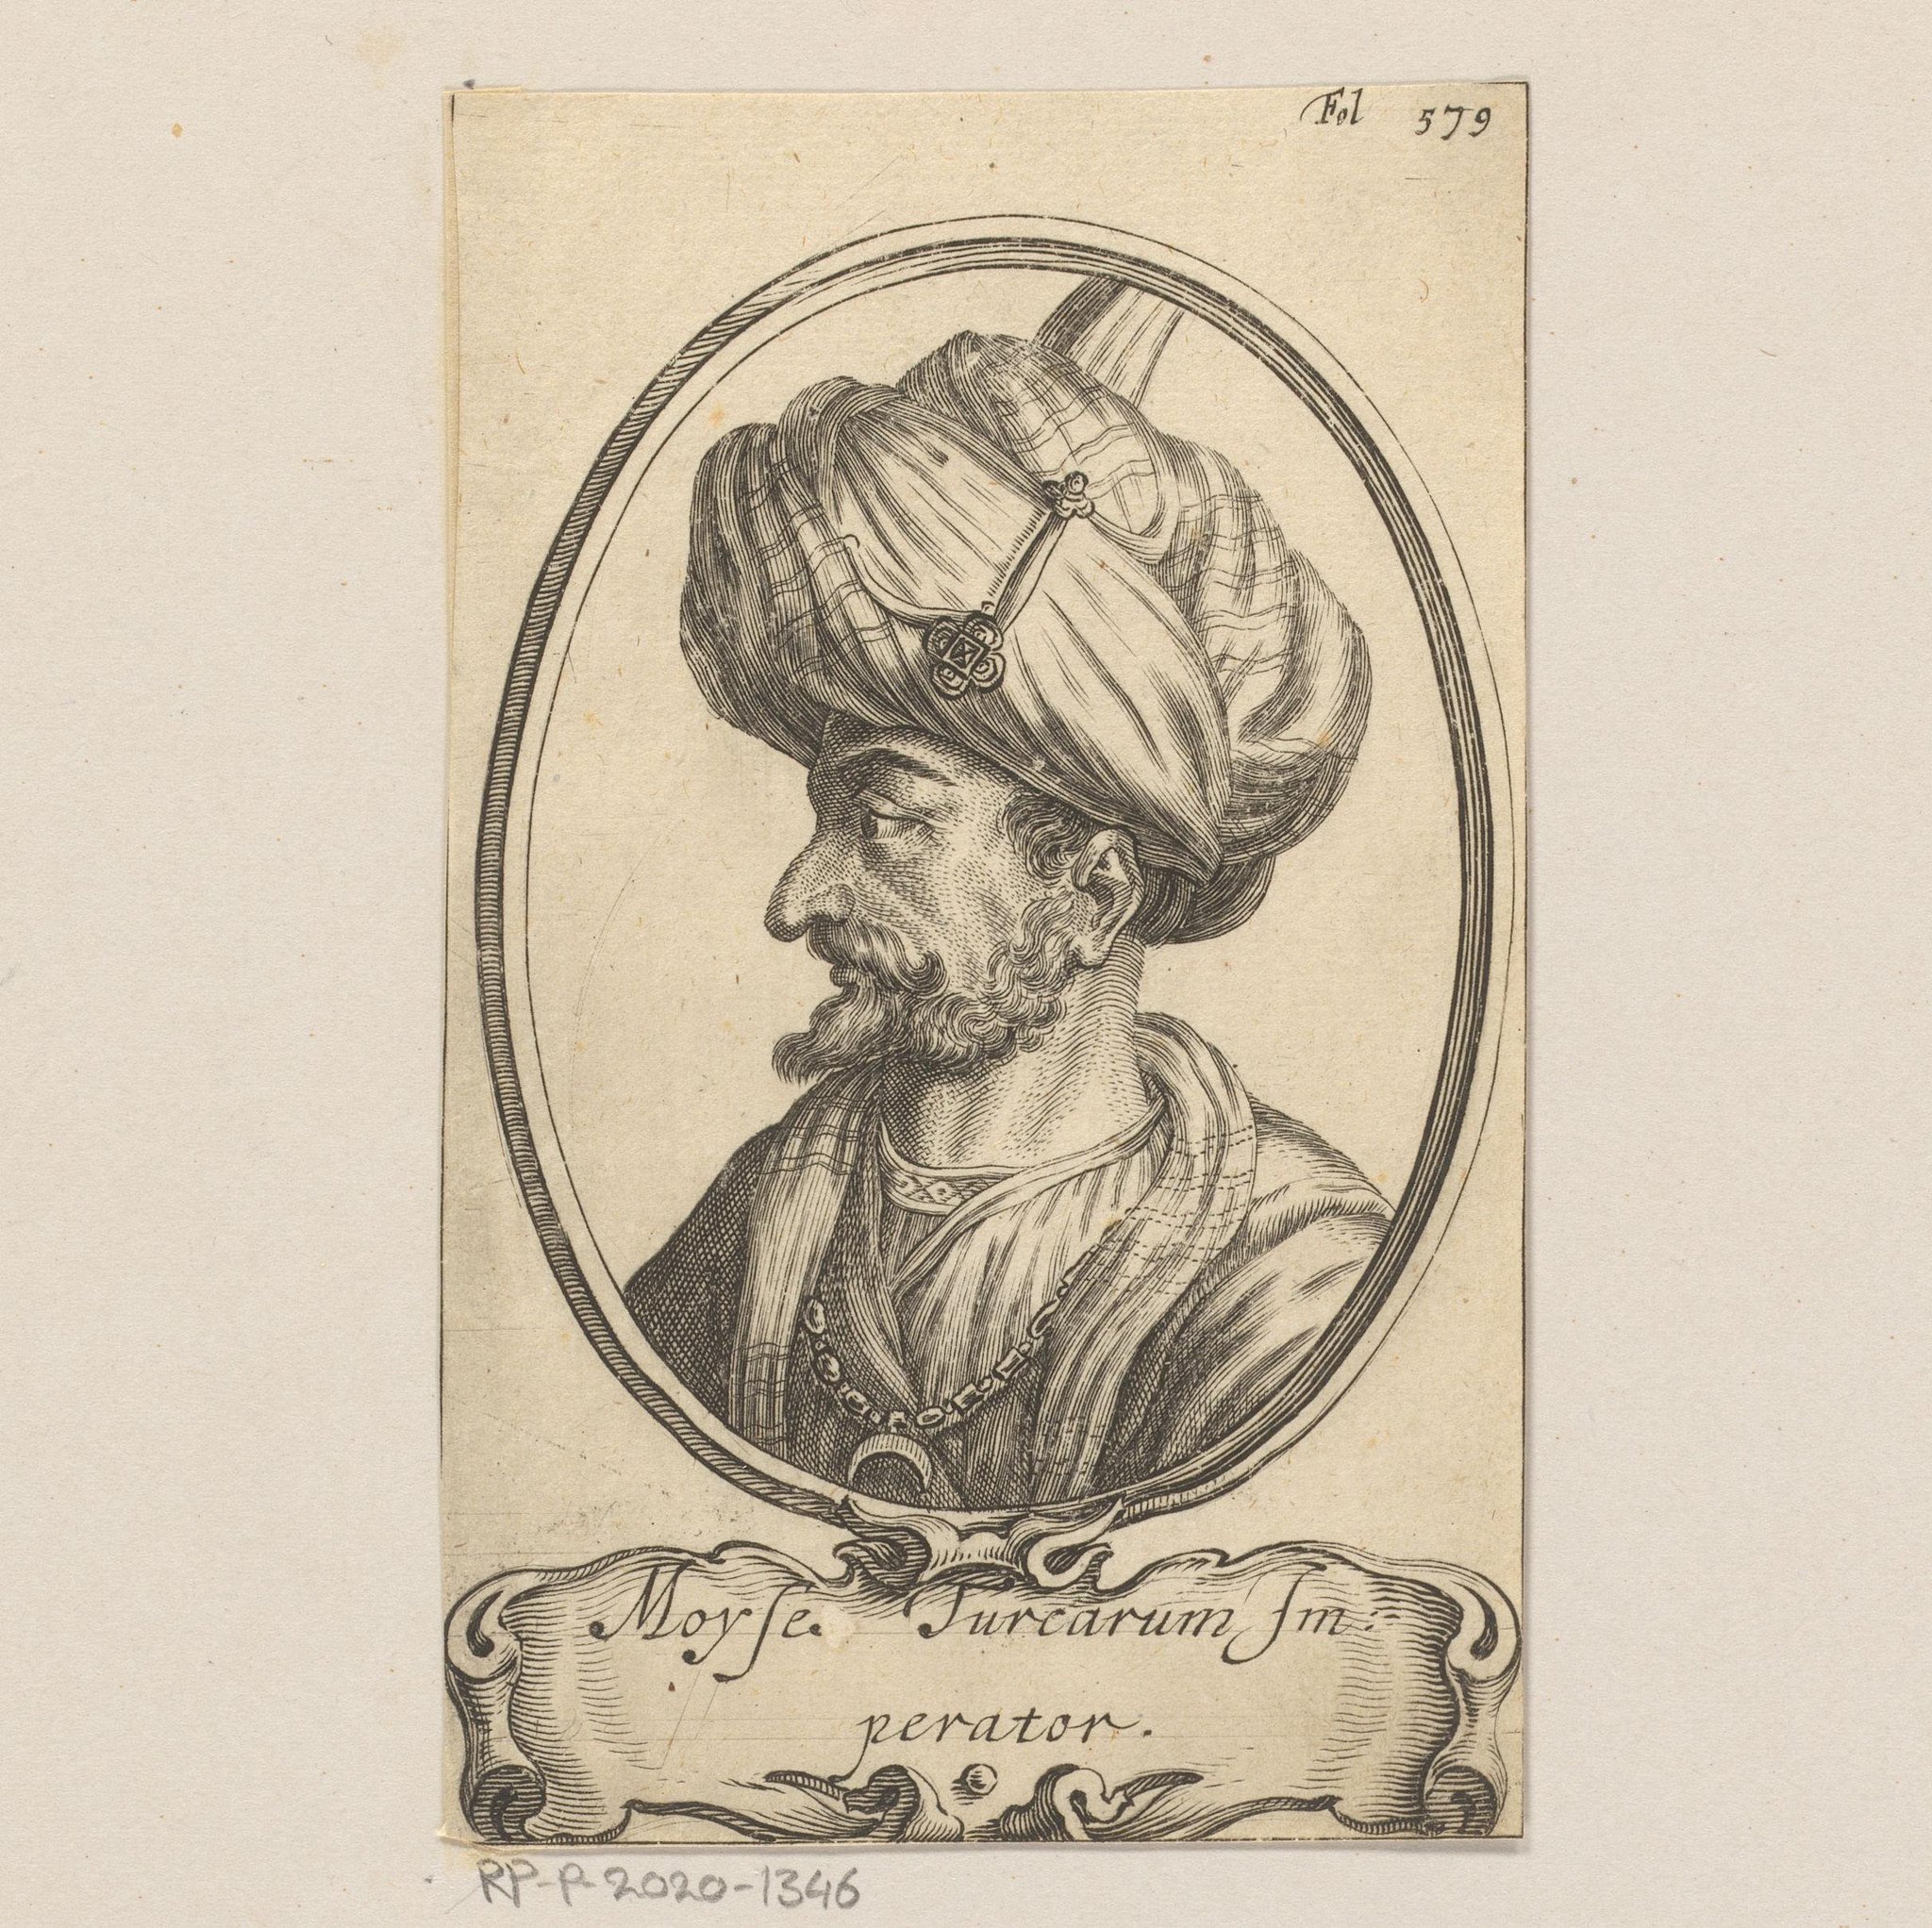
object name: book illustration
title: Portret van Musa Çelebi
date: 1656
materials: paper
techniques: engraving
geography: dordrecht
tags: historical persons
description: Prent waarschijnlijk uit: Bos, Lambert van den. Het konincklyk treur-toonneel, ofte op- en ondergangh der keyseren, koningen en vorsten (...). Dordrecht: Jacobus Savry, 1656, dl. 1, p. 553.